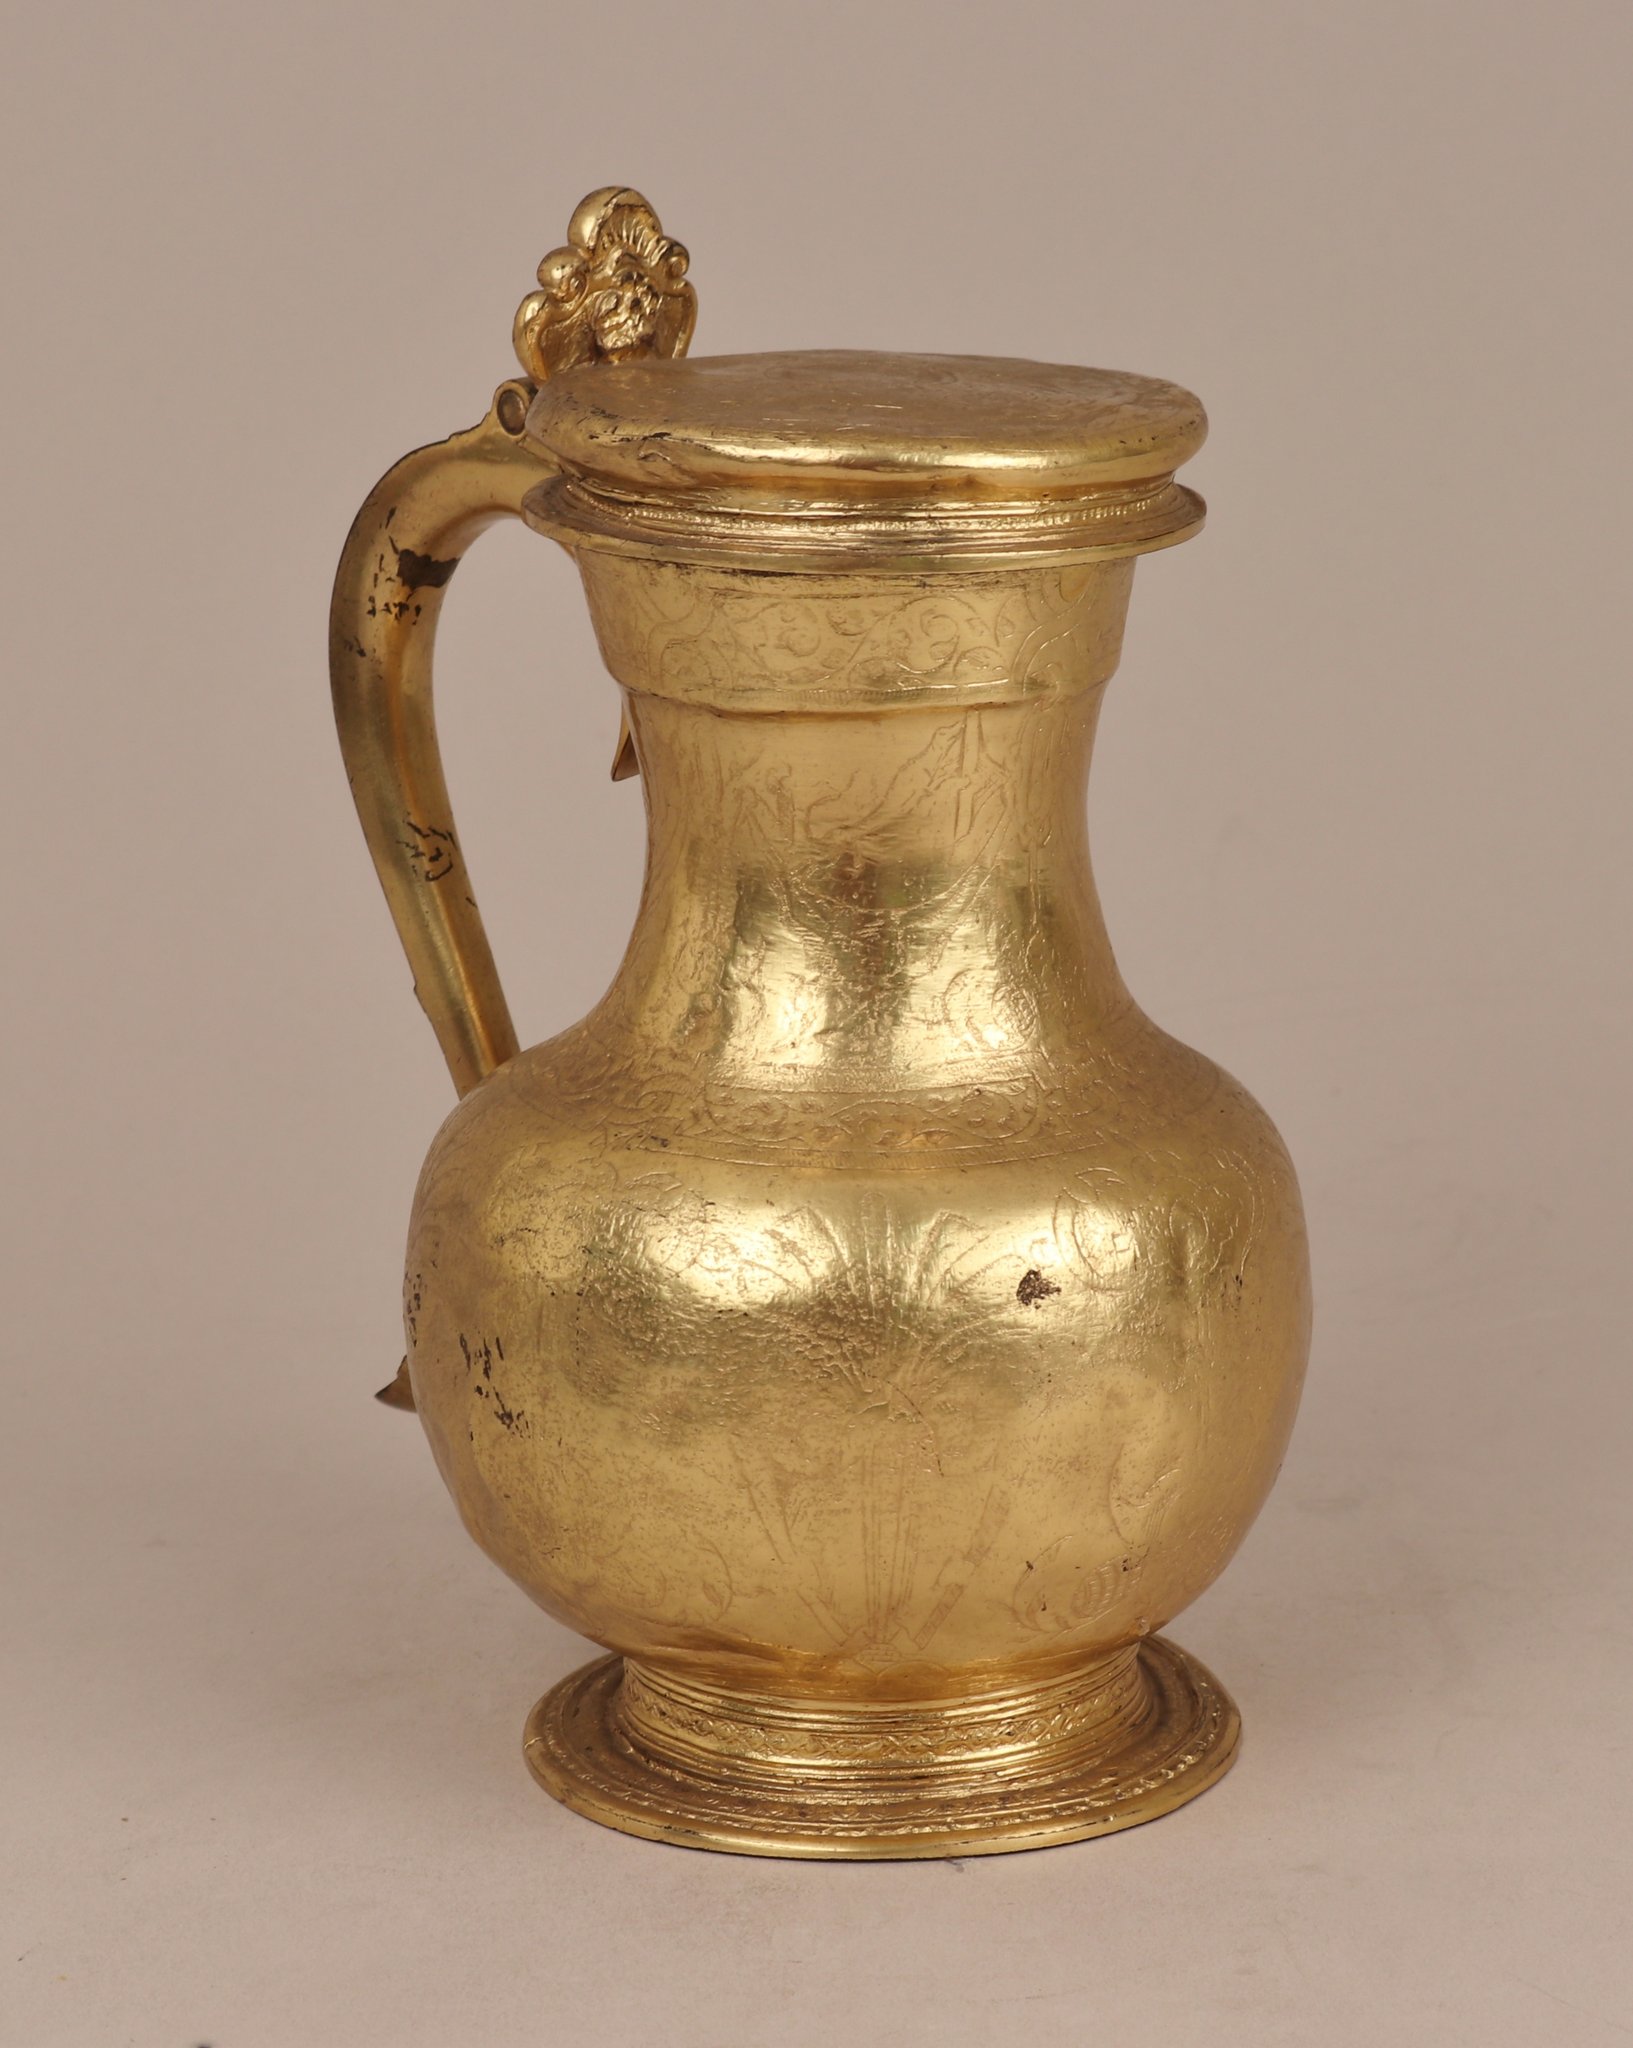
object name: flagon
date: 1801-1900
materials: metal, silver